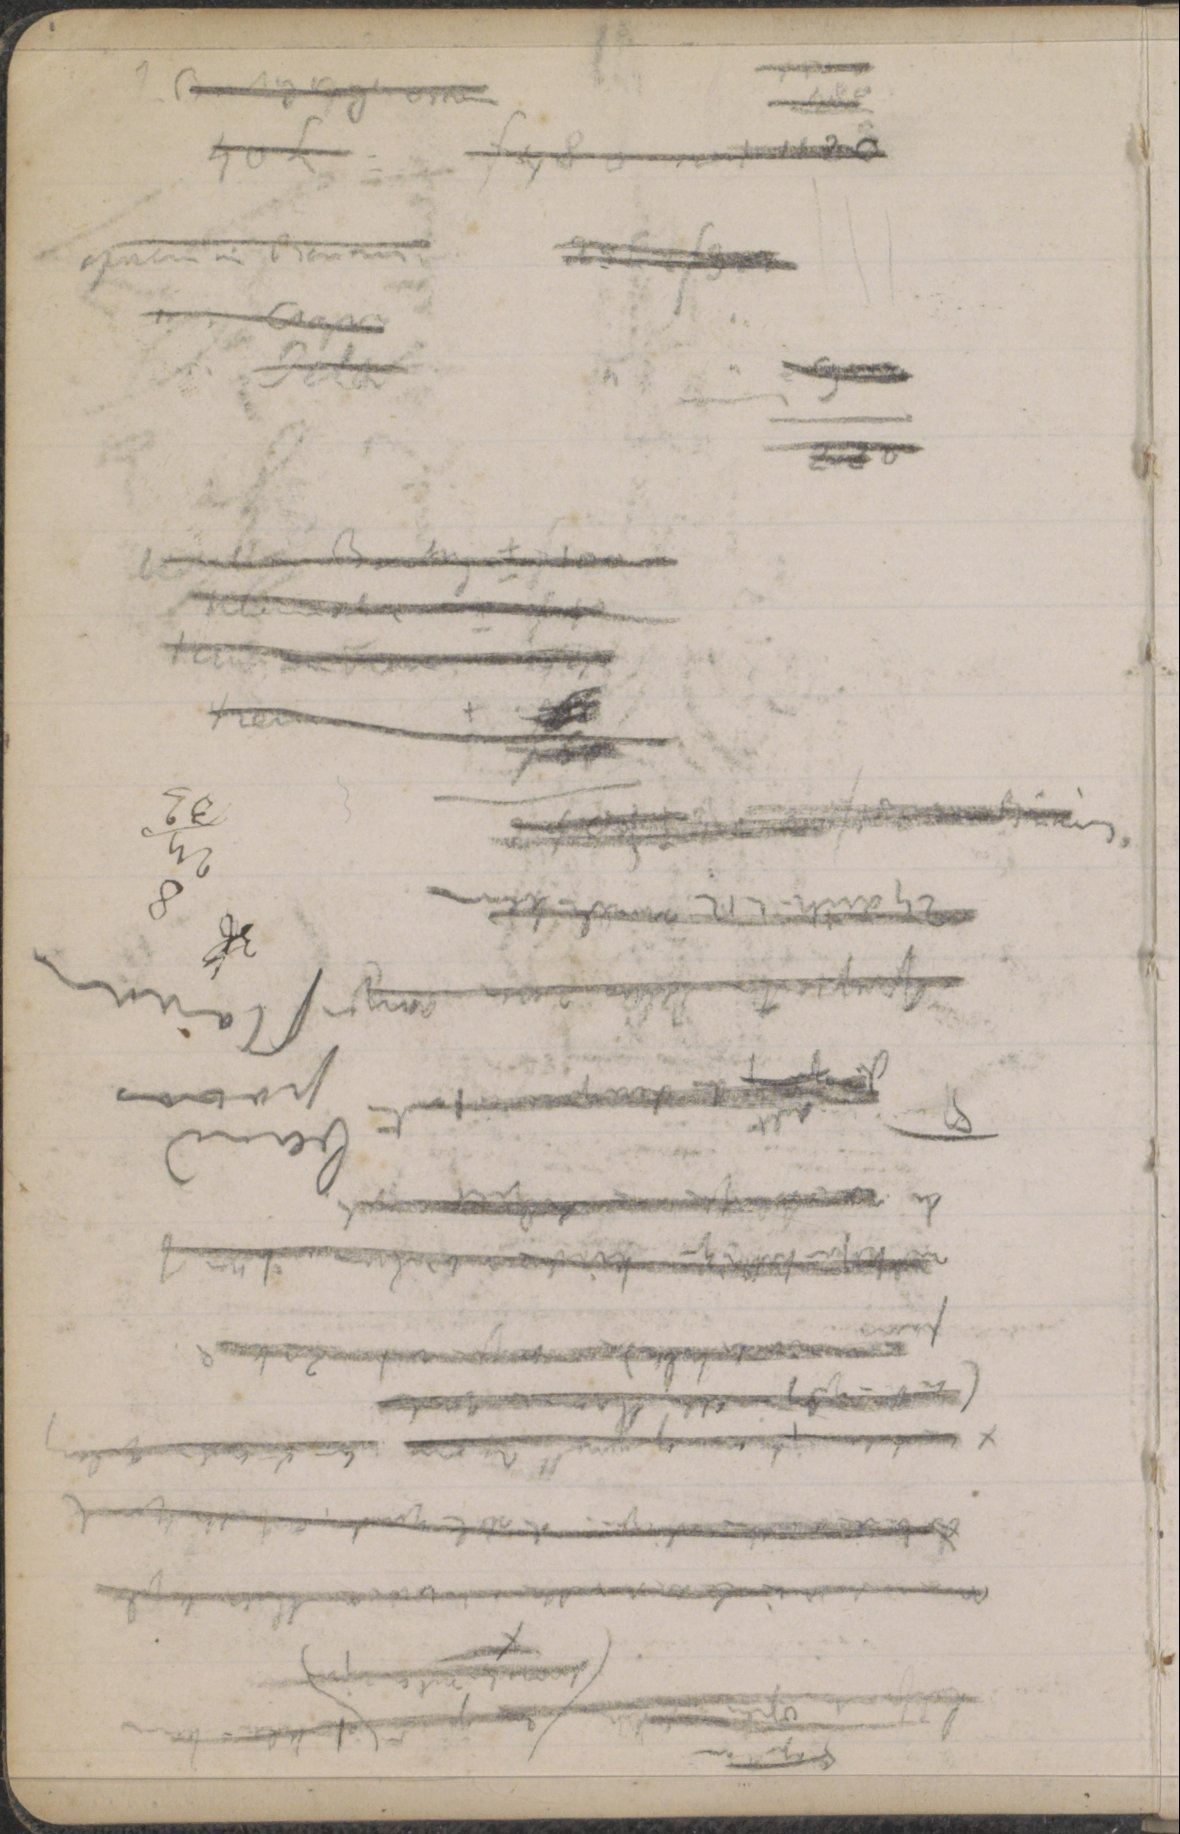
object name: sketchbook leaf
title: Notities en berekening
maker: marius bauer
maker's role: draughtsman, print maker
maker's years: 1867-1932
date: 1897-1898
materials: ink, pencil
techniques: pen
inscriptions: annotation: ‘[...]’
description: Pagina 1 uit een schetsboek met 84 bladen.